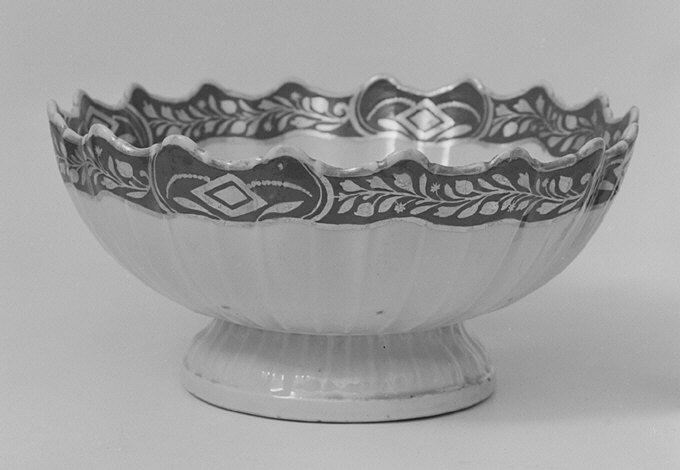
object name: bowl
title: Bowl (part of a service)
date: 1785-1800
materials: hard paste porcelain